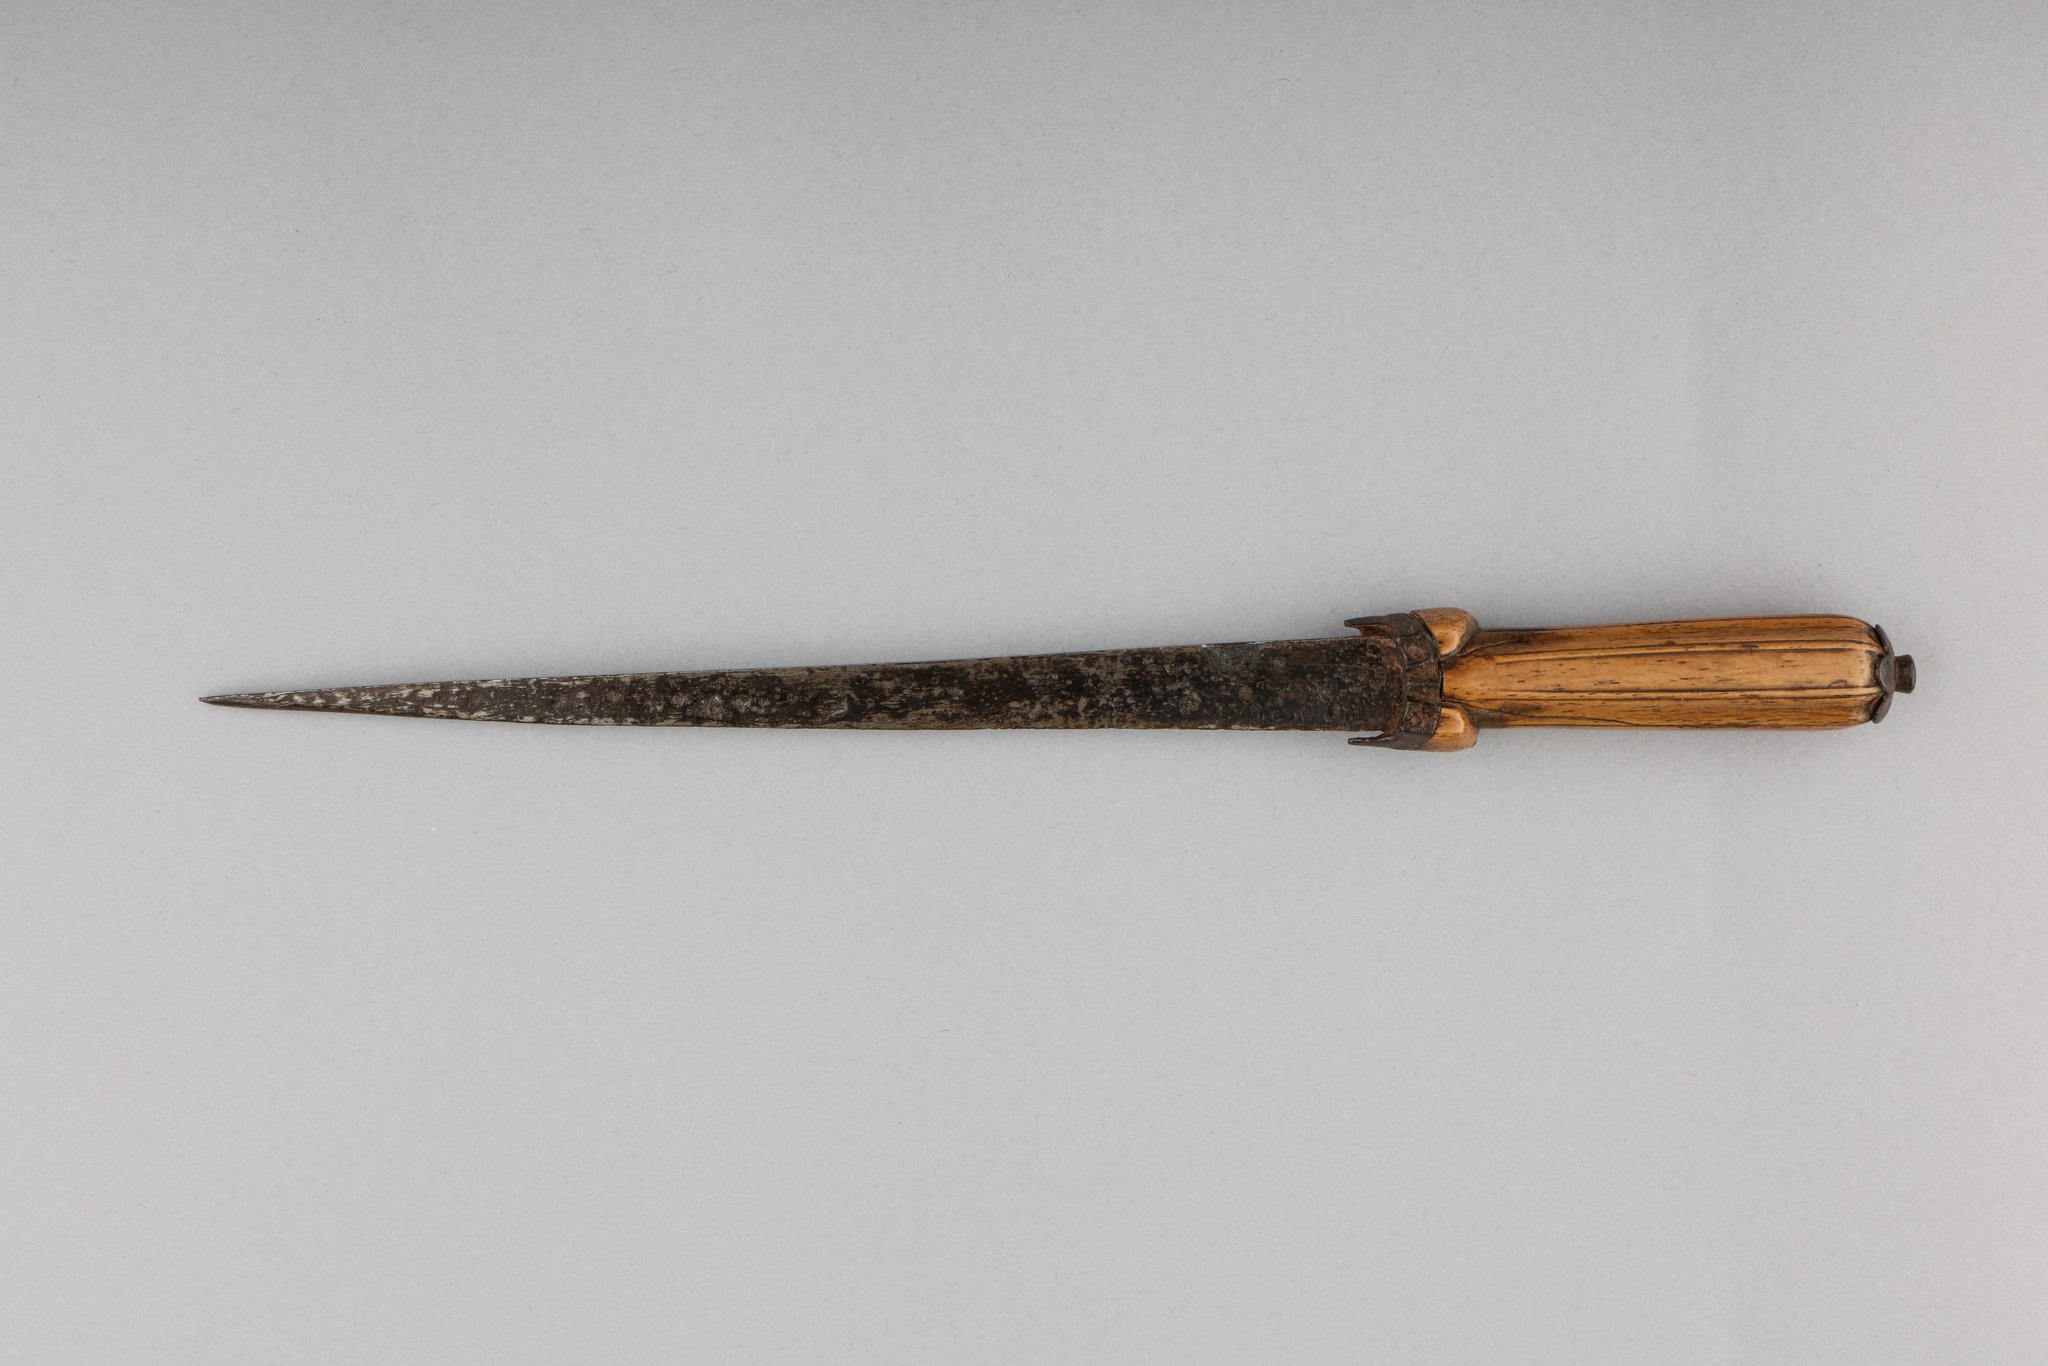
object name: ballock knife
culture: british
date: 1501-1600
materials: horn, steel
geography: england